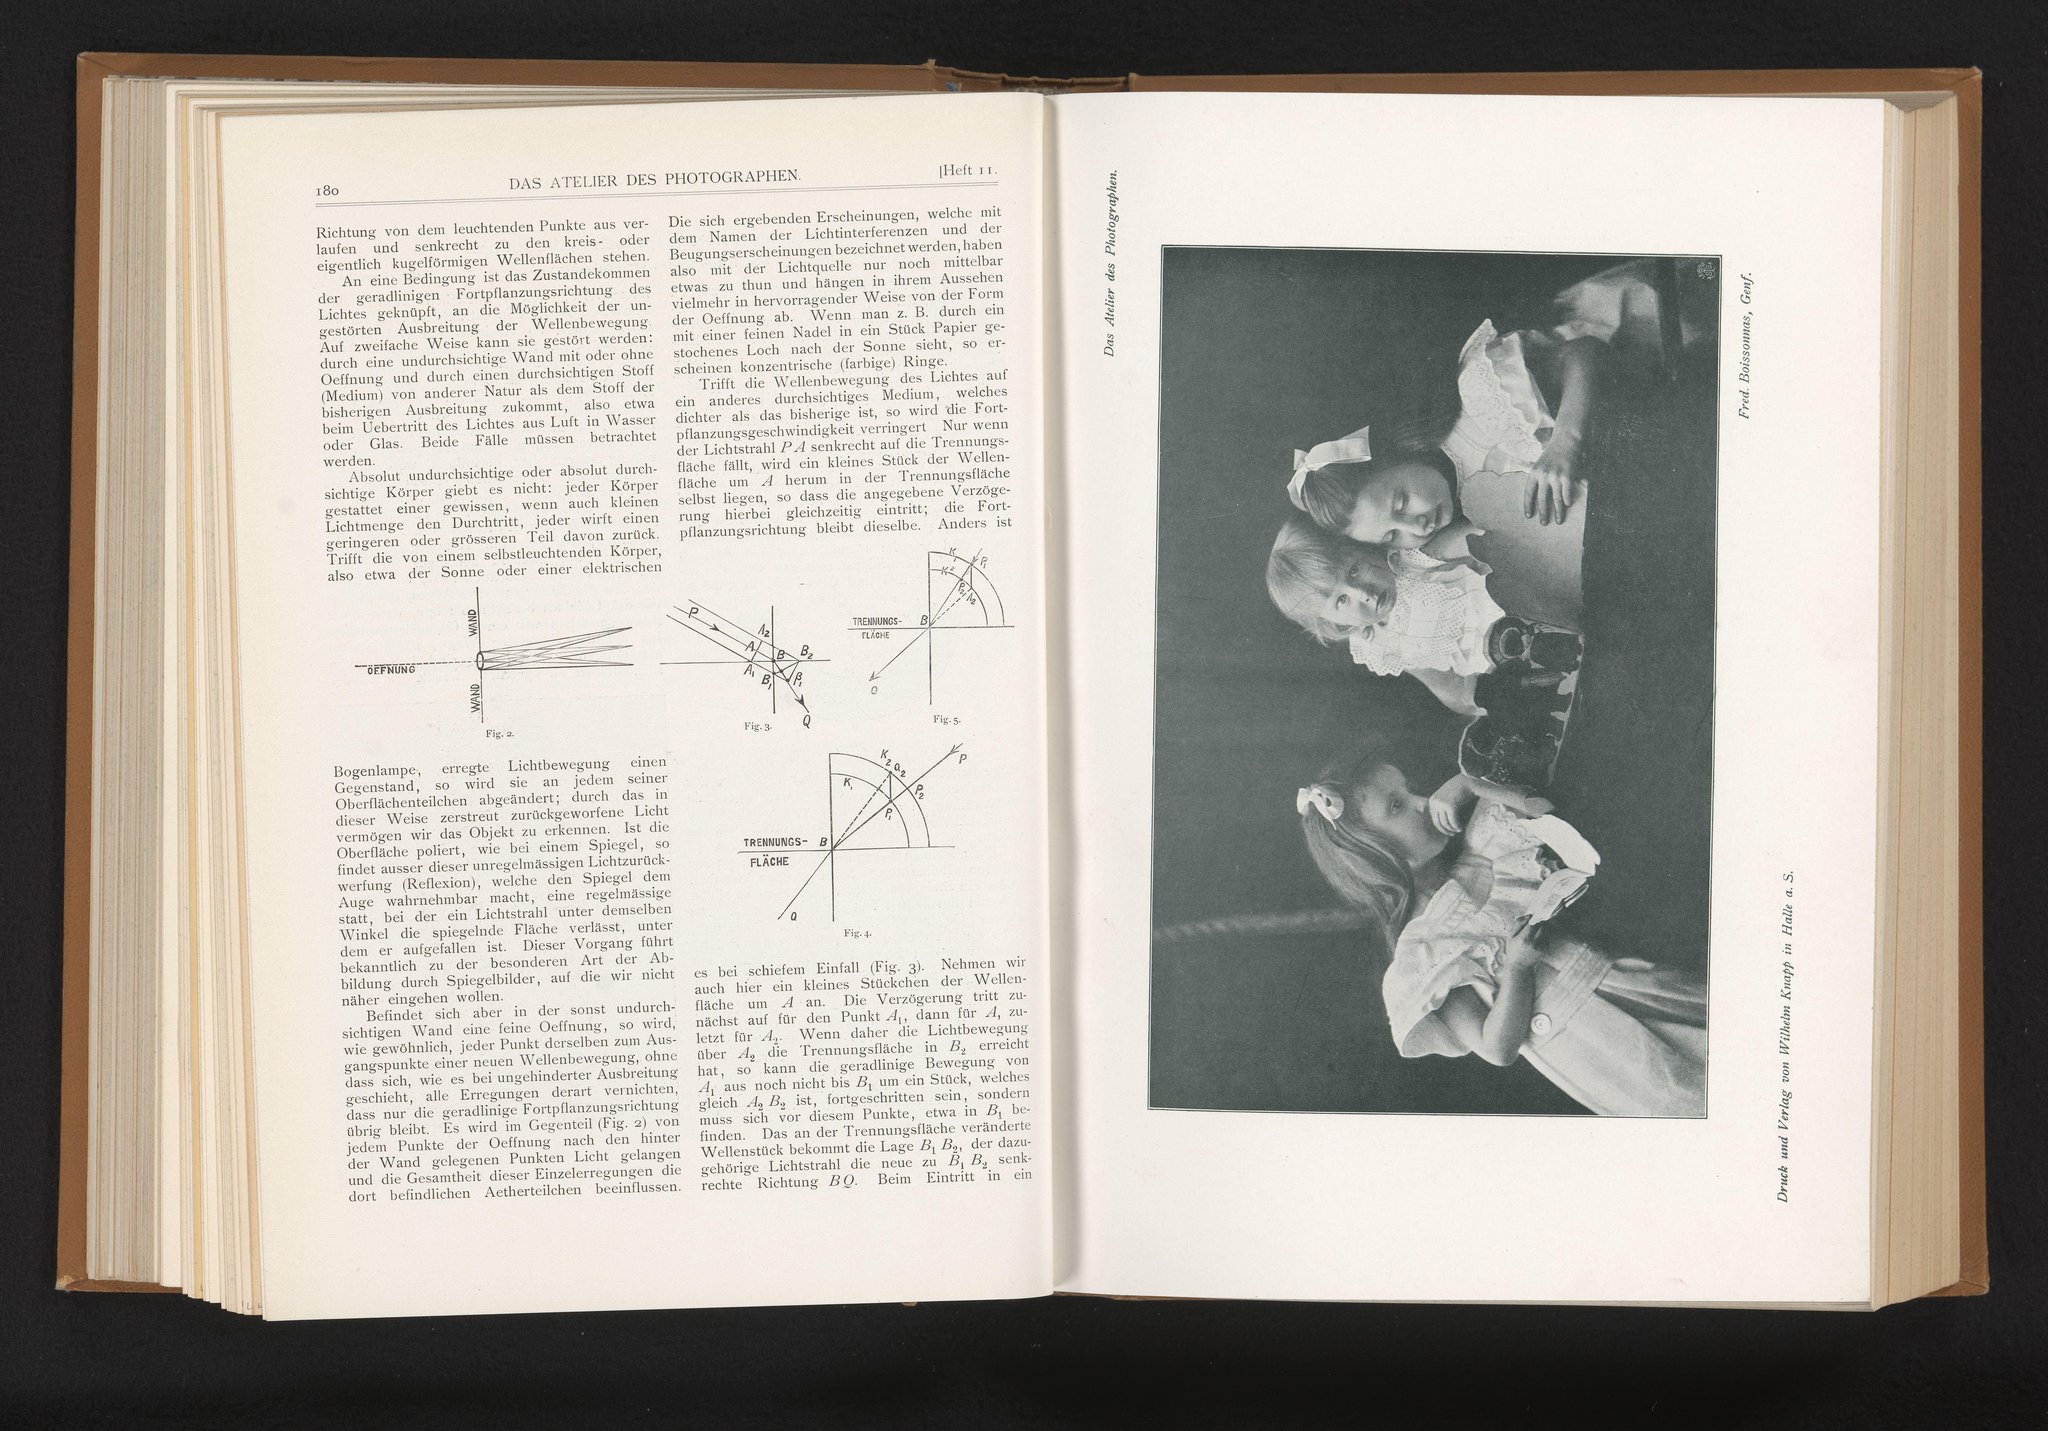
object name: photomechanical print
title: Portret van drie onbekende meisjes met een stuk speelgoed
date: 1895-1900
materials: paper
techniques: autotype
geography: leipzig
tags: historical persons - bb - woman, girl (child between toddler and youth)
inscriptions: monogram: ‘LEIPZIG/ S G’, inscription: ‘Das Atelier des Photographen.’